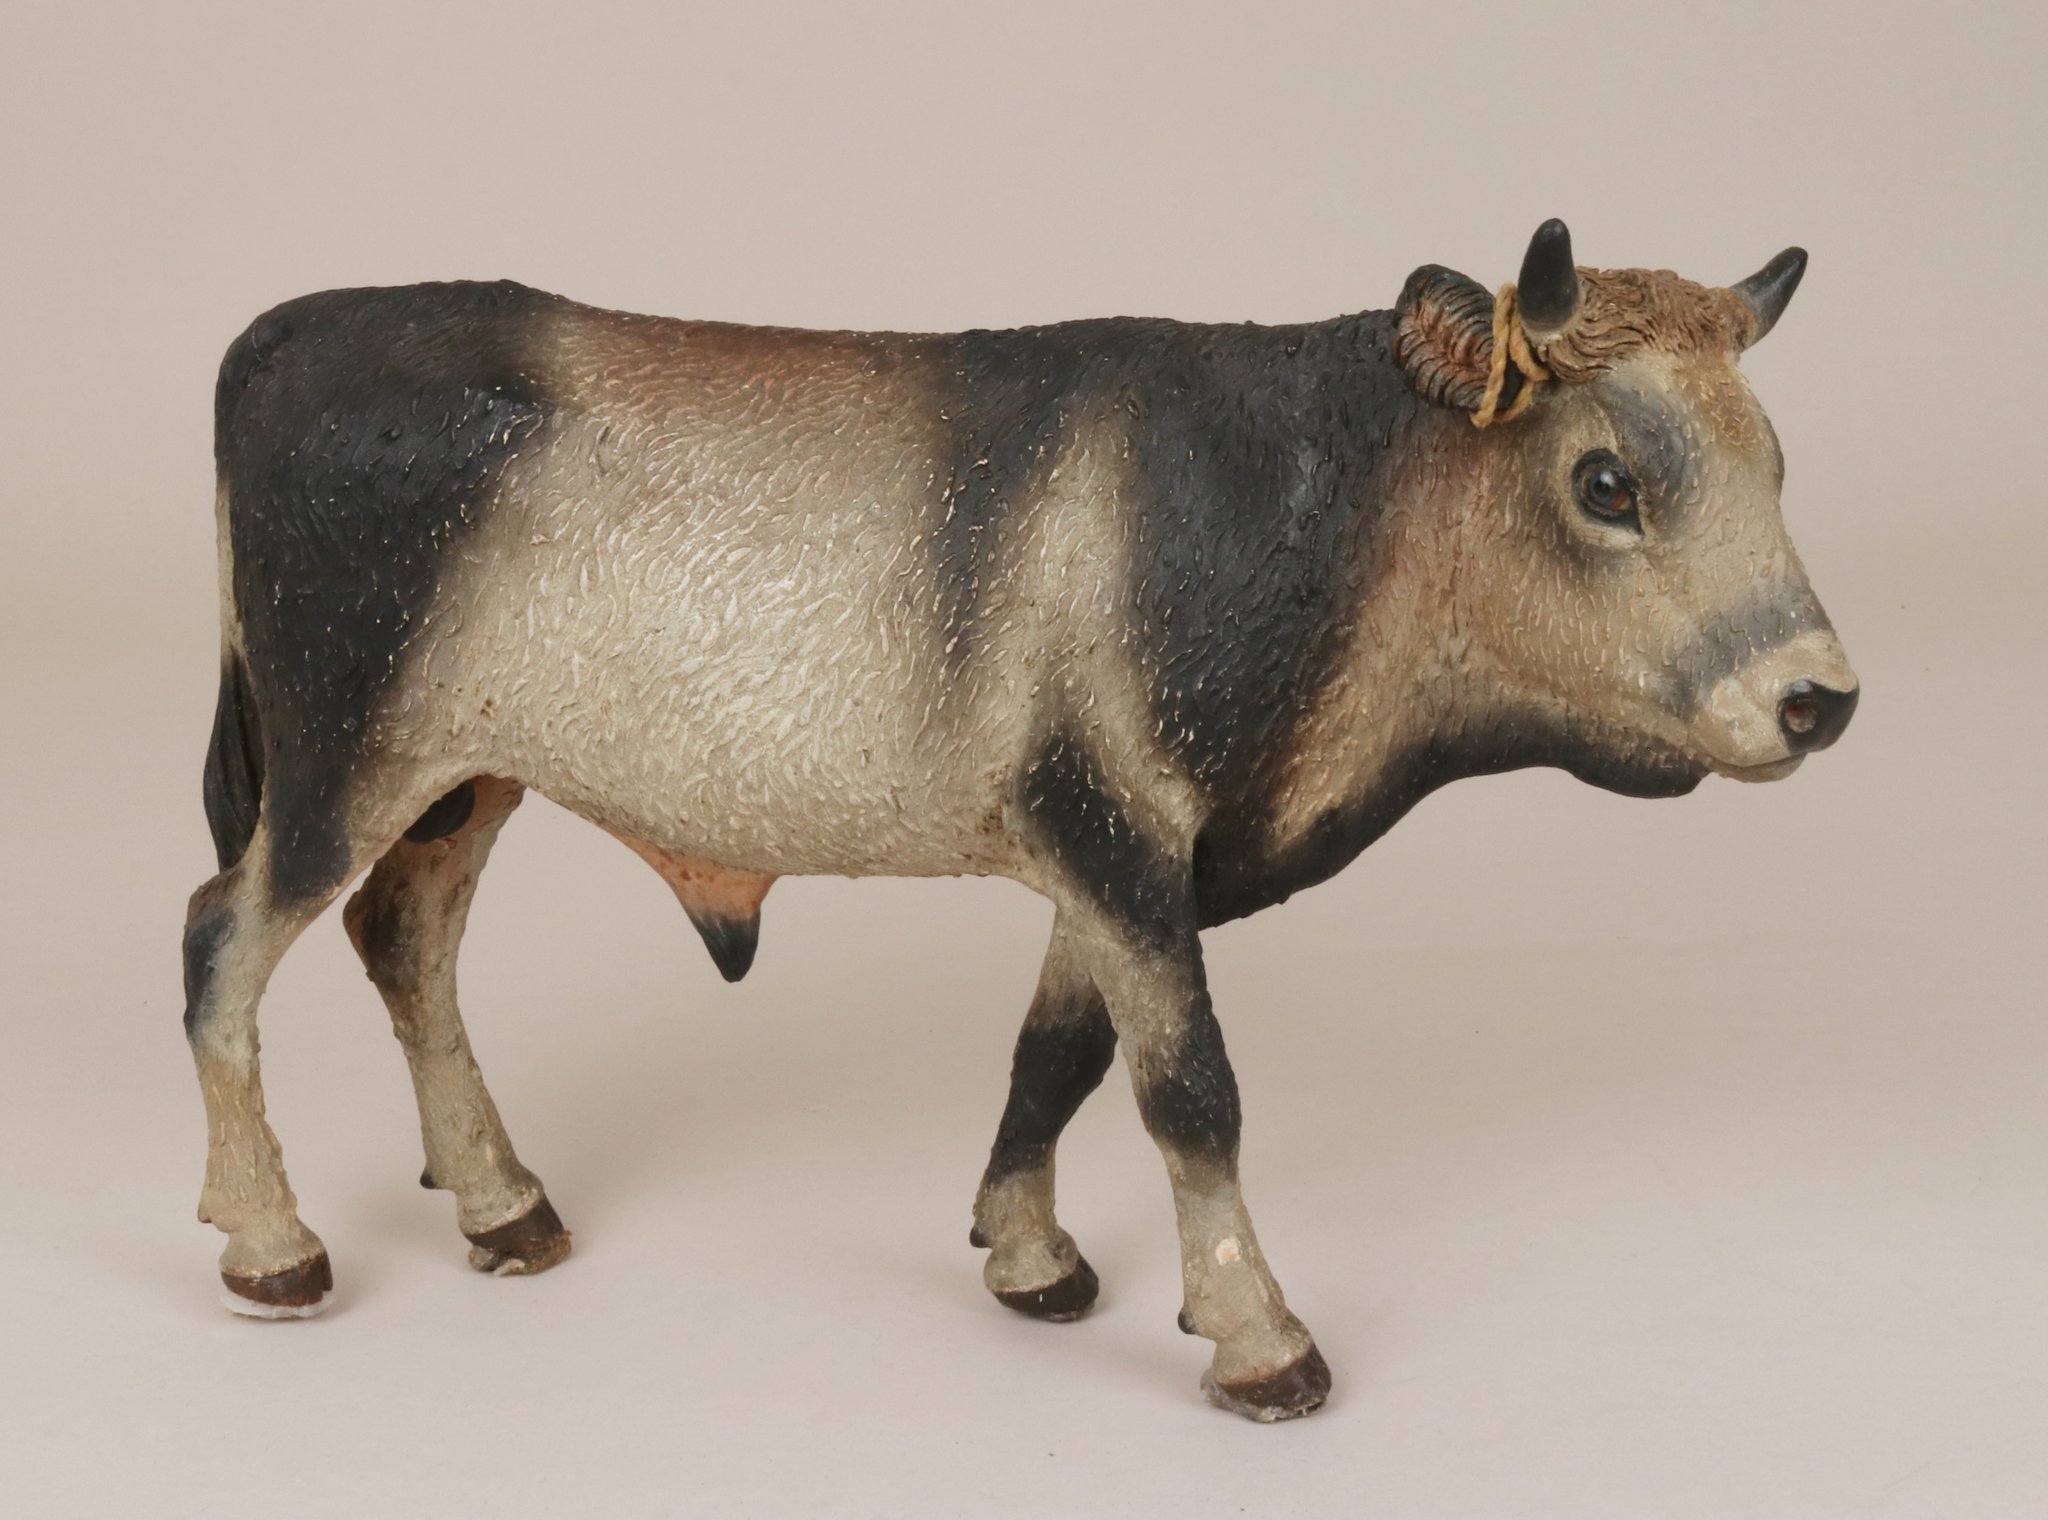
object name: crèche figure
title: Ox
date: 1701-1800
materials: terracotta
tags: ox